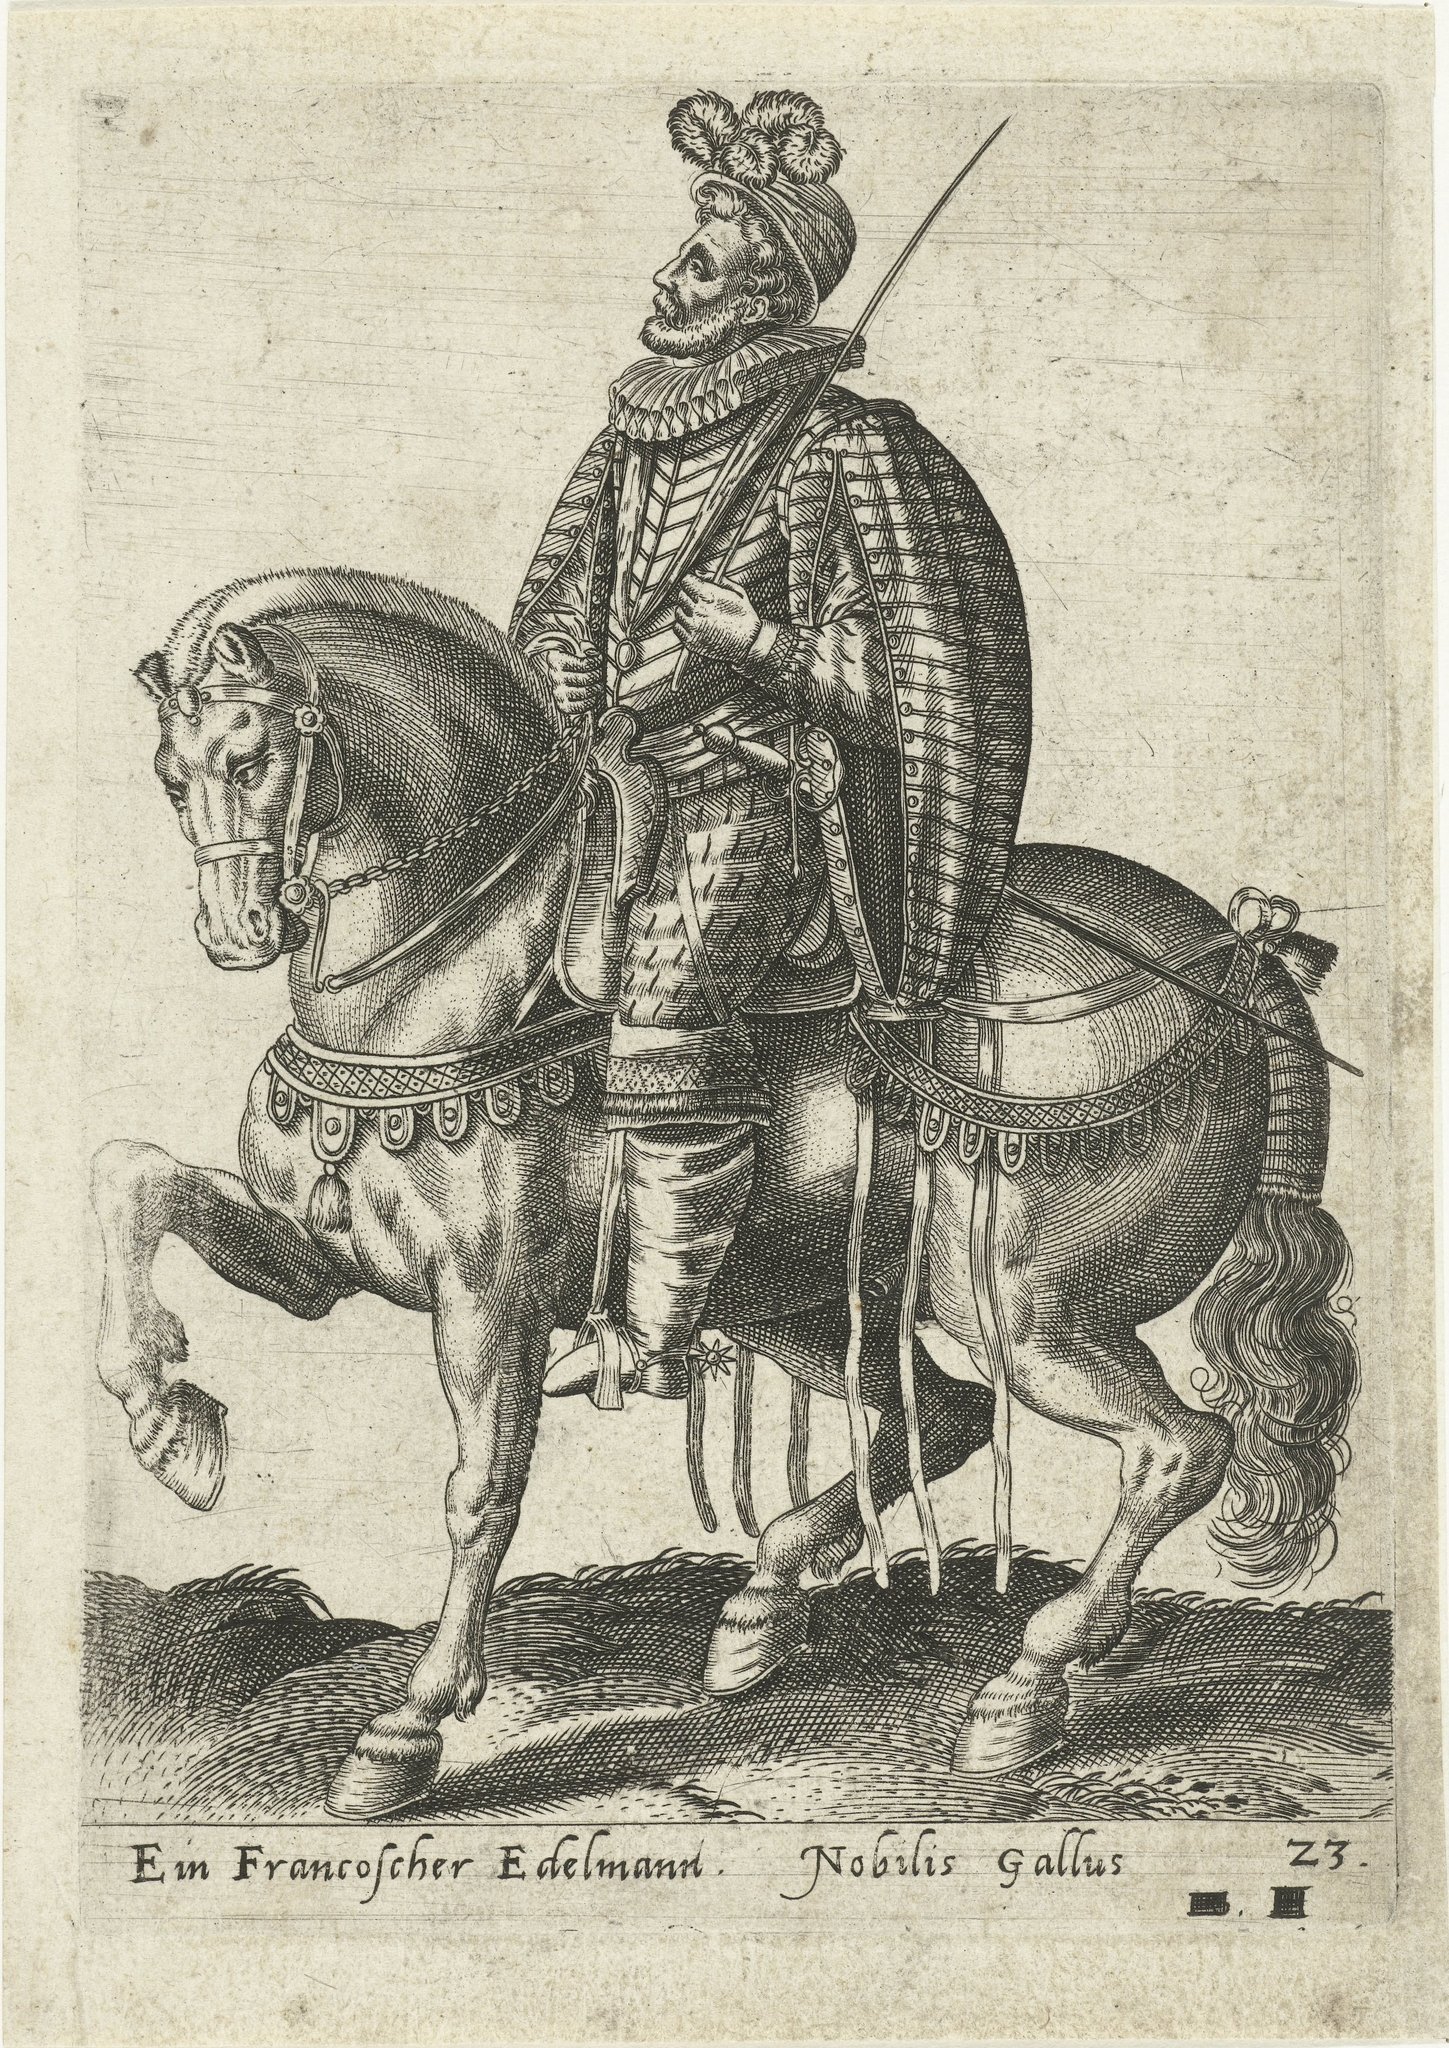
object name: costume print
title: Franse edelman te paard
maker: abraham de bruyn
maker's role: print maker, publisher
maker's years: 1540-1587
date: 1577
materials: paper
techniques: engraving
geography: cologne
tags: europeans (with name), warfare; military affairs (+ cavalry, horsemen), folk costume, regional costume, nobility and patriciate; chivalry, knighthood, whip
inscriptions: collector's mark: Lugt 2228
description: Prent oorspronkelijk verschenen in 'Equitum descripcio, quomodo equestres copie, nostra hac aetate, in sua armatura, per cunttas, videlicet Europae, Asiae et Affrice, nationes in re militare sese habent nunc primum', Keulen 1577.